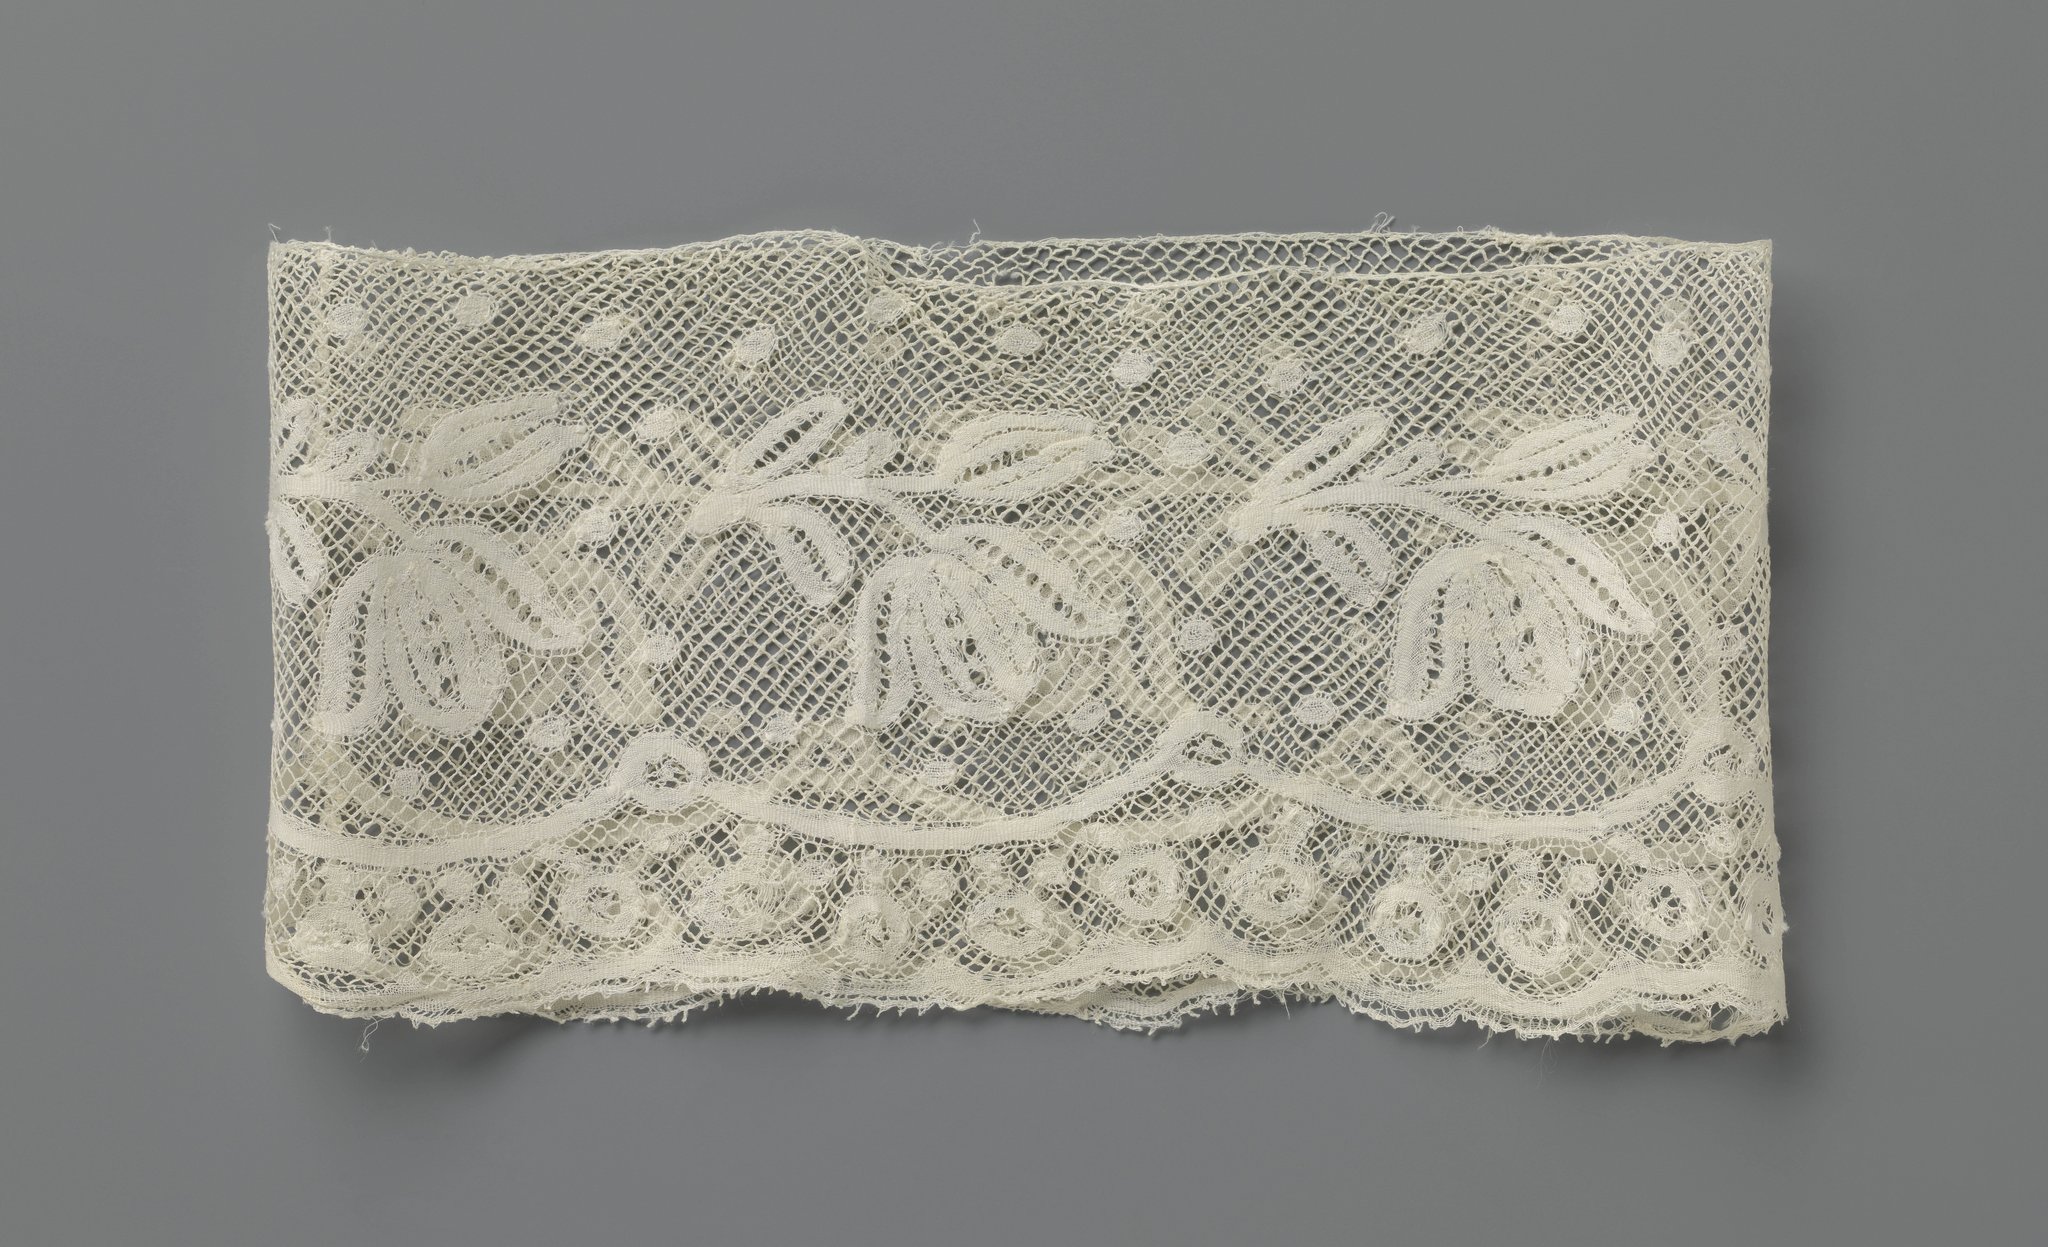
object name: cuff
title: Manchet van kloskant met hangende tulp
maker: Anonymous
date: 1900-1909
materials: linen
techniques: lace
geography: netherlands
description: Manchet van naturelkleurige kloskant: Valenciennes-kant. Op een grove traliegrond (vierkante tralie), dat met 'pailletten' is bezaaid, staat een lopend patroon. Eenzijdig gerichte hangende tulpen staan los boven gestrekte schulpen van een guirlande met afhangende bessen.